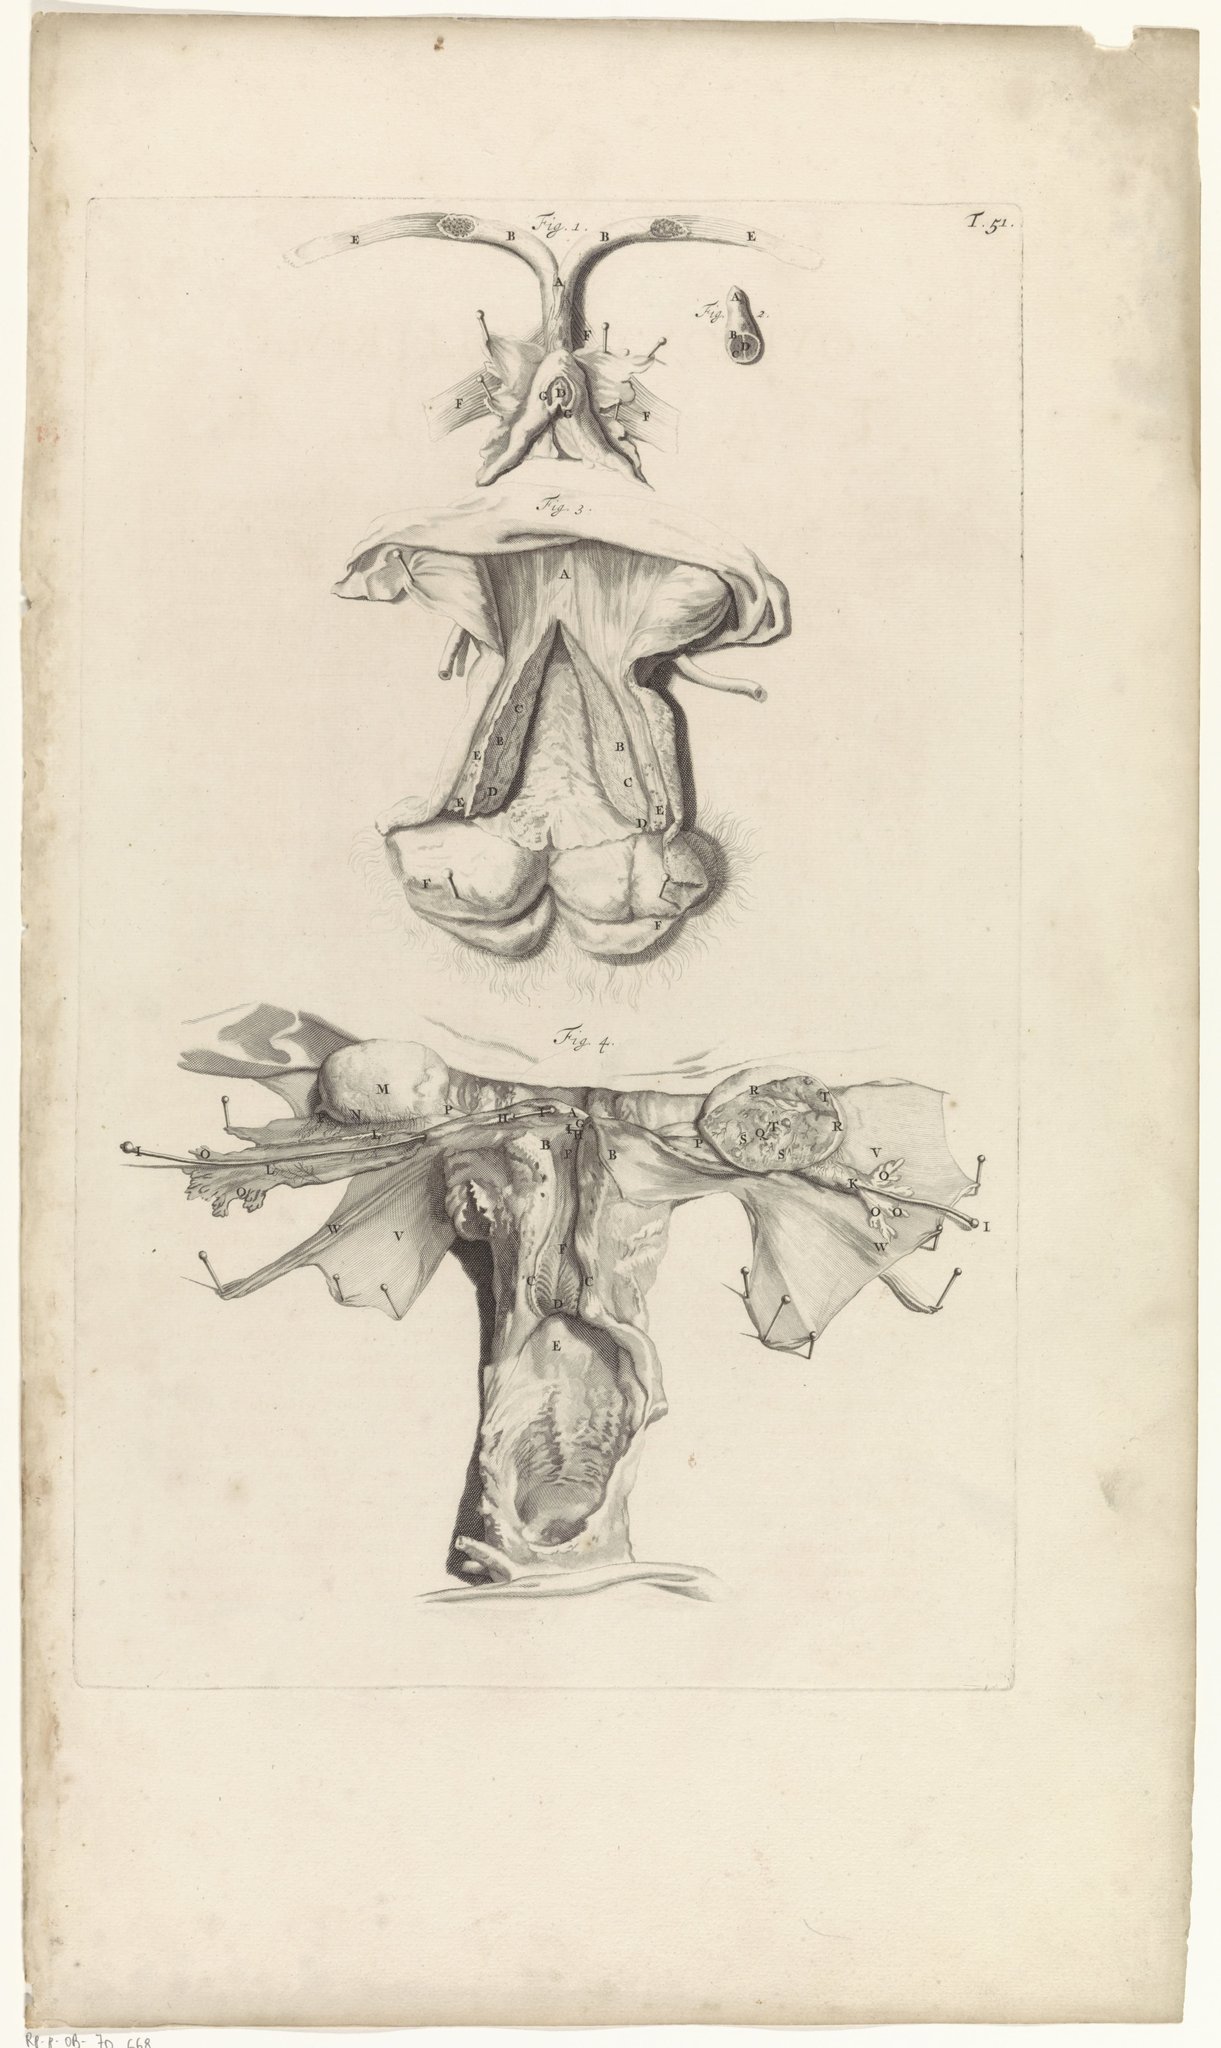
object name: book illustration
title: Anatomische studie van het vrouwelijk voortplantingsstelsel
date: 1685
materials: paper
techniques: engraving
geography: amsterdam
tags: female sexual organs, womb, uterus, ovaries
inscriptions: collector's mark: Lugt 2228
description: Boekillustratie voor Bidloo, Godefridus. Anatomia humani corporis centum & quinque tabulis, per art. G. de Lairesse ad vivum delineatis, de monstrata, veterum recentiorumque inventis explicata plurimisque, hactenus non detectis, illustrata. Amsterdam: Weduwe Joannes van Someren, Hendrick Boom en erven Dirk Boom, 1685.